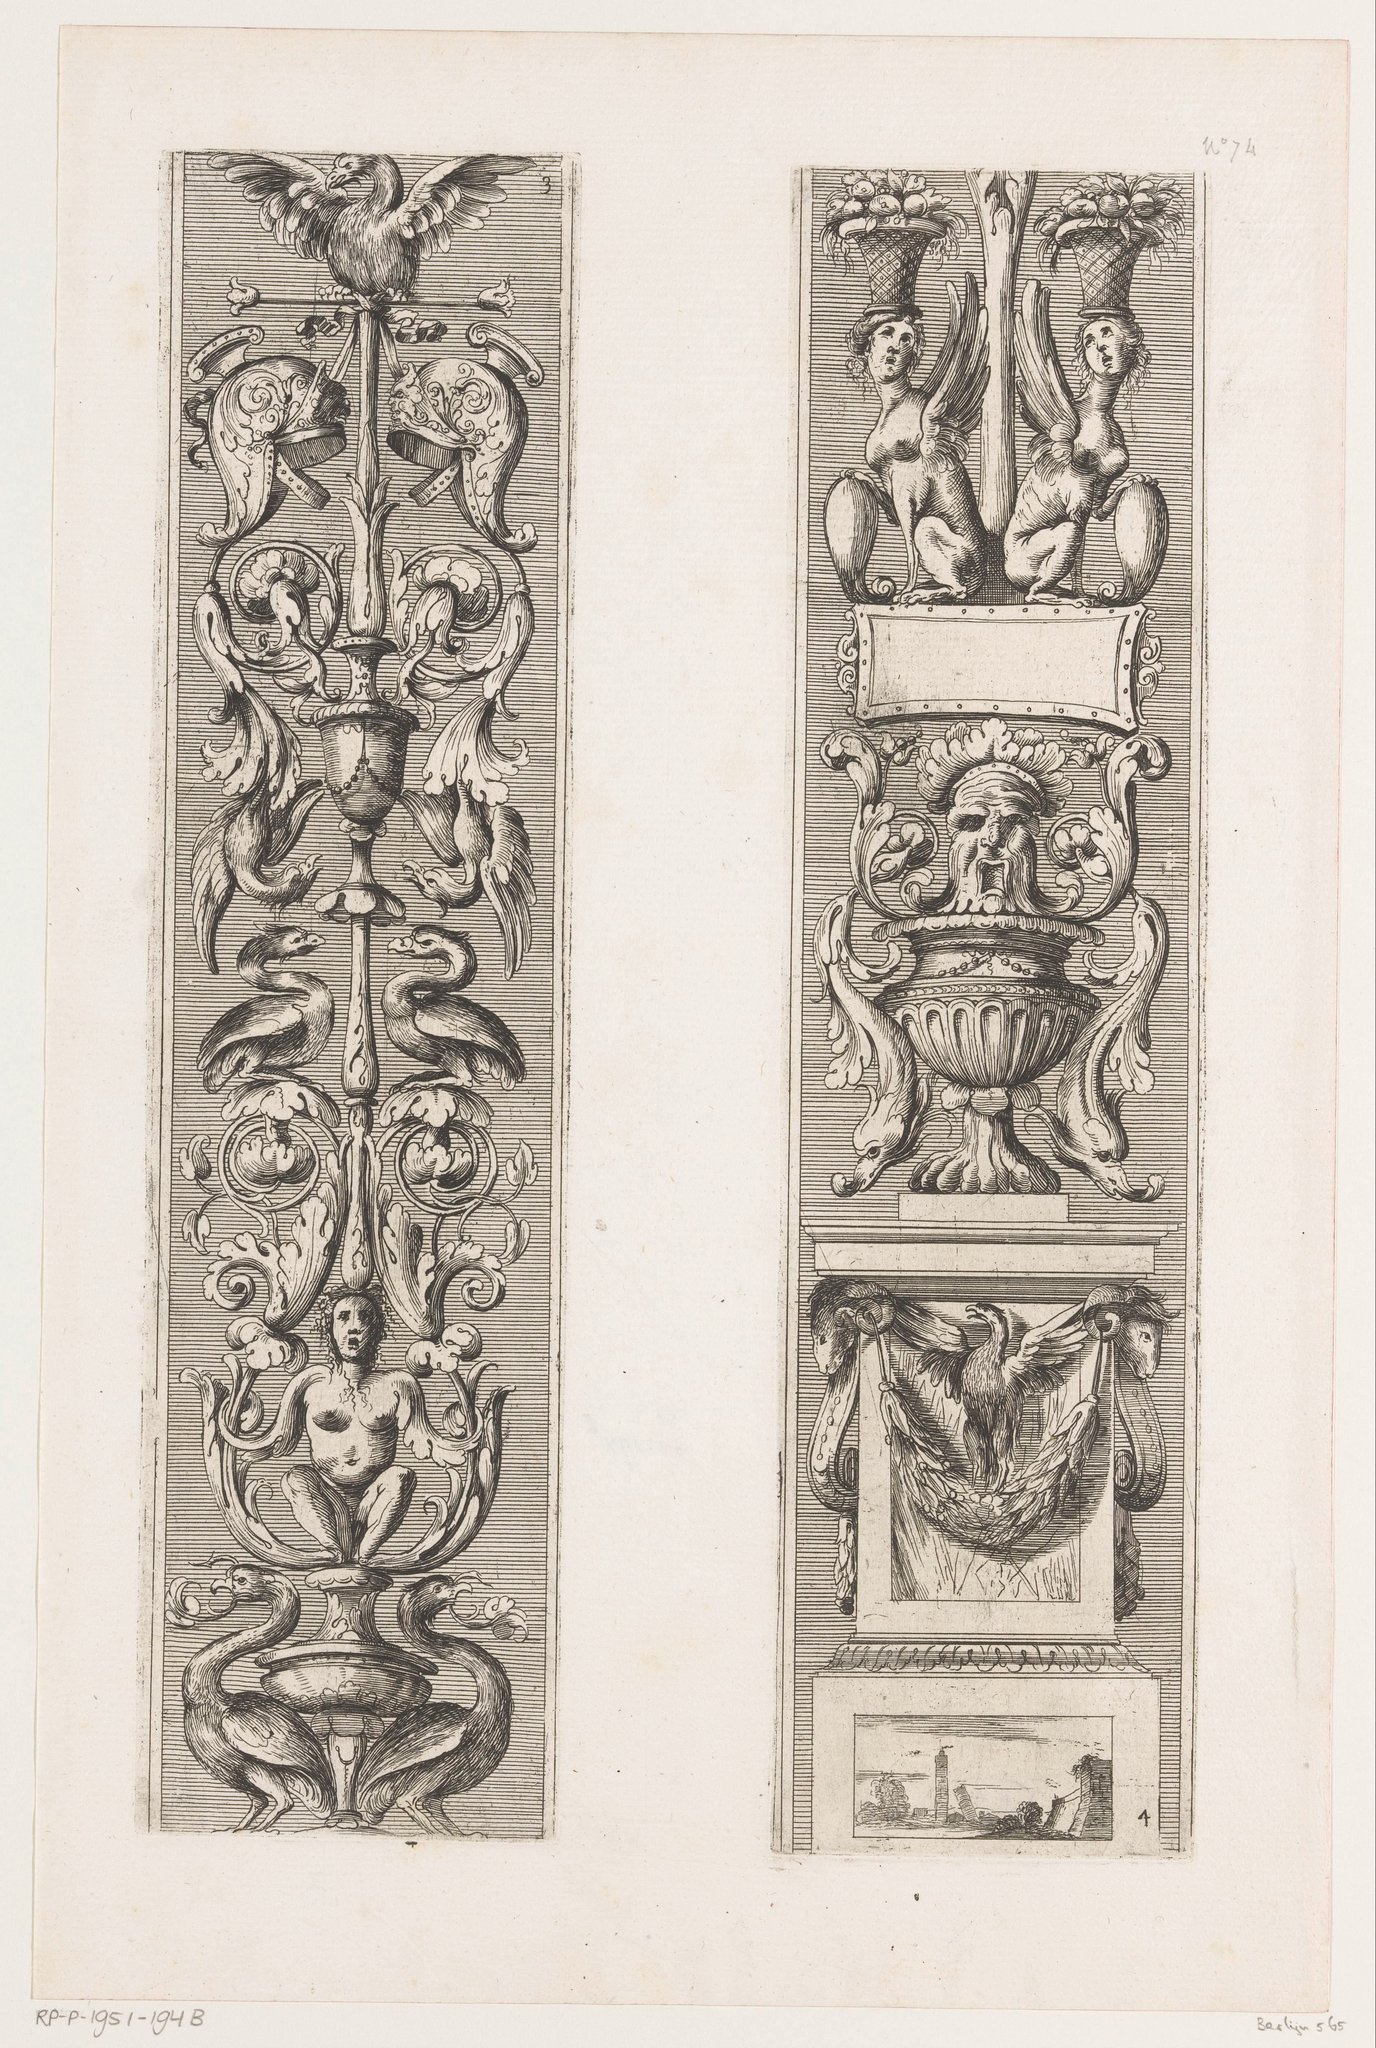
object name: print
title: Twee kandelabers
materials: paper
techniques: etching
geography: italy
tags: ornament ~ candelabrum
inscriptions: collector's mark: Lugt 2228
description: Deze prent maakt deel uit van een reeks van 48 prenten plus een titelprent. Mitelli maakte tekeningen van marmeren pilasterdecoraties van de poort van de S. Bartolomeo di Porta Ravegnana in Bologna. Deze prenten zijn vervolgens naar die tekeningen gemaakt.